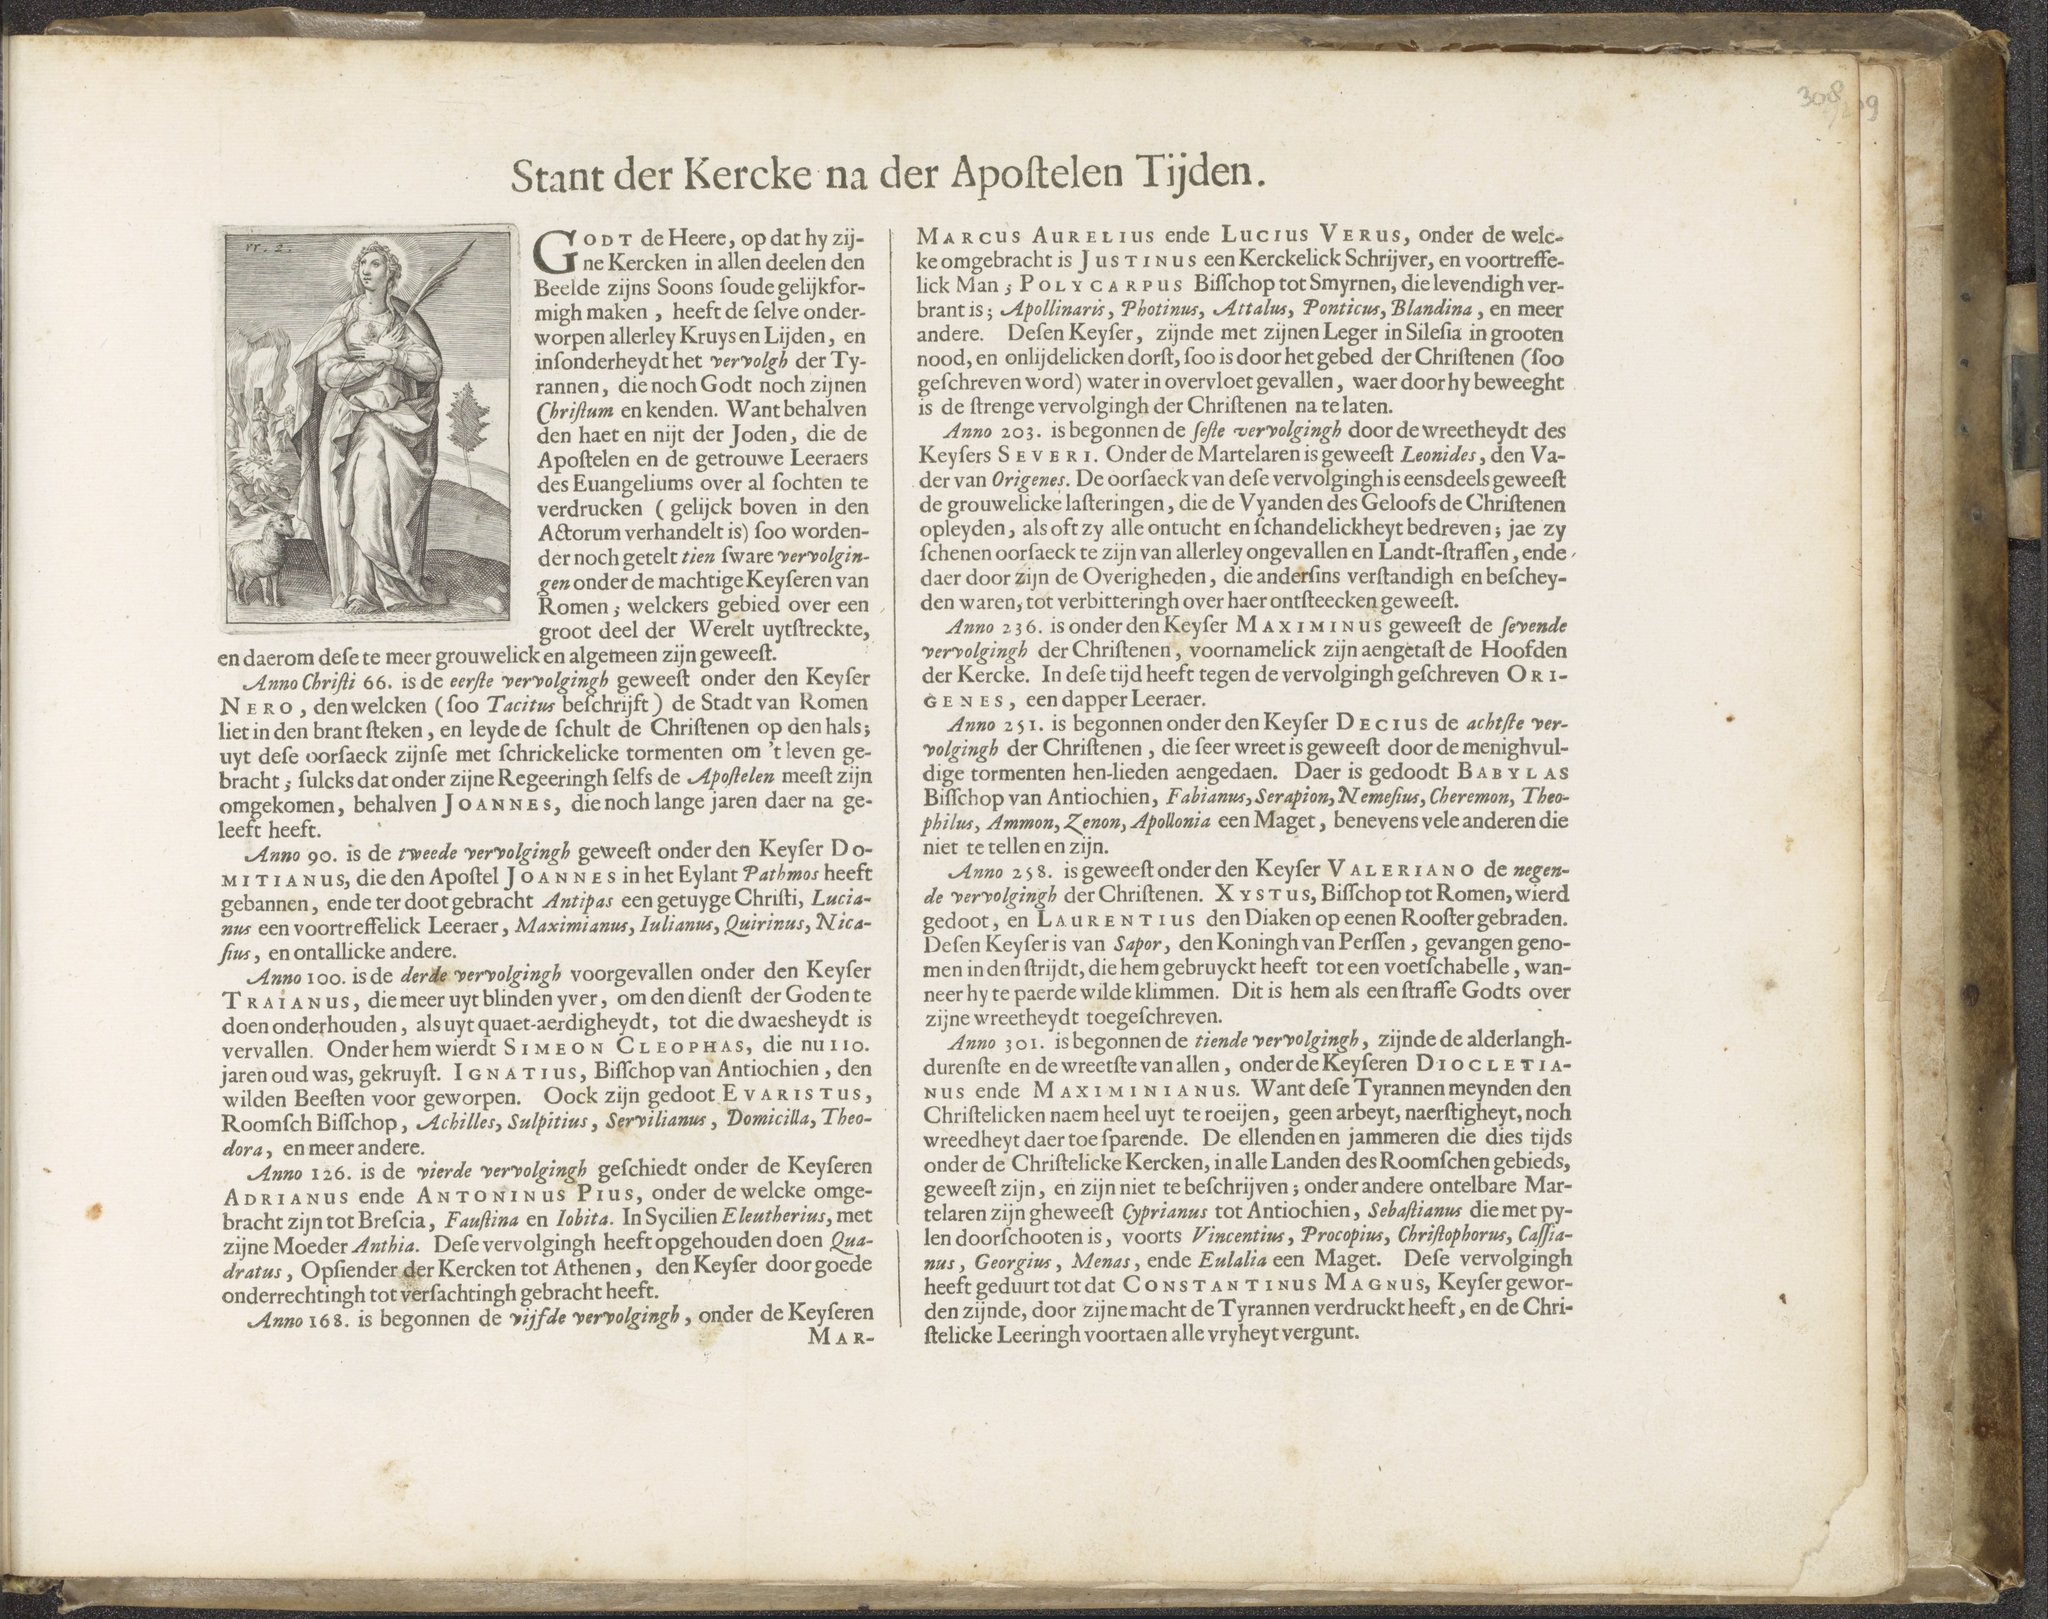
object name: text sheet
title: Heilige Agnes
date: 1653-1654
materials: paper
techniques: engraving, letterpress printing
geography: amsterdam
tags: the virgin martyr agnes of rome; possible attributes: lamb, ring, st. agnes tied to the stake remains unharmed; the executioners are consumed by the fire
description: De heilige Agnes met palmtak en lam. Op de achtergrond staat ze op de brandstapel. Omdat haar lichaam echter door de vlammen ongedeerd bleef werd Agnes vervolgens onthoofd. Linksboven: rr.2. Met begeleidende tekst over de vervolging van de Christenen ten tijde van het Romeinse keizerrijk. Het blad maakt deel uit van een album.